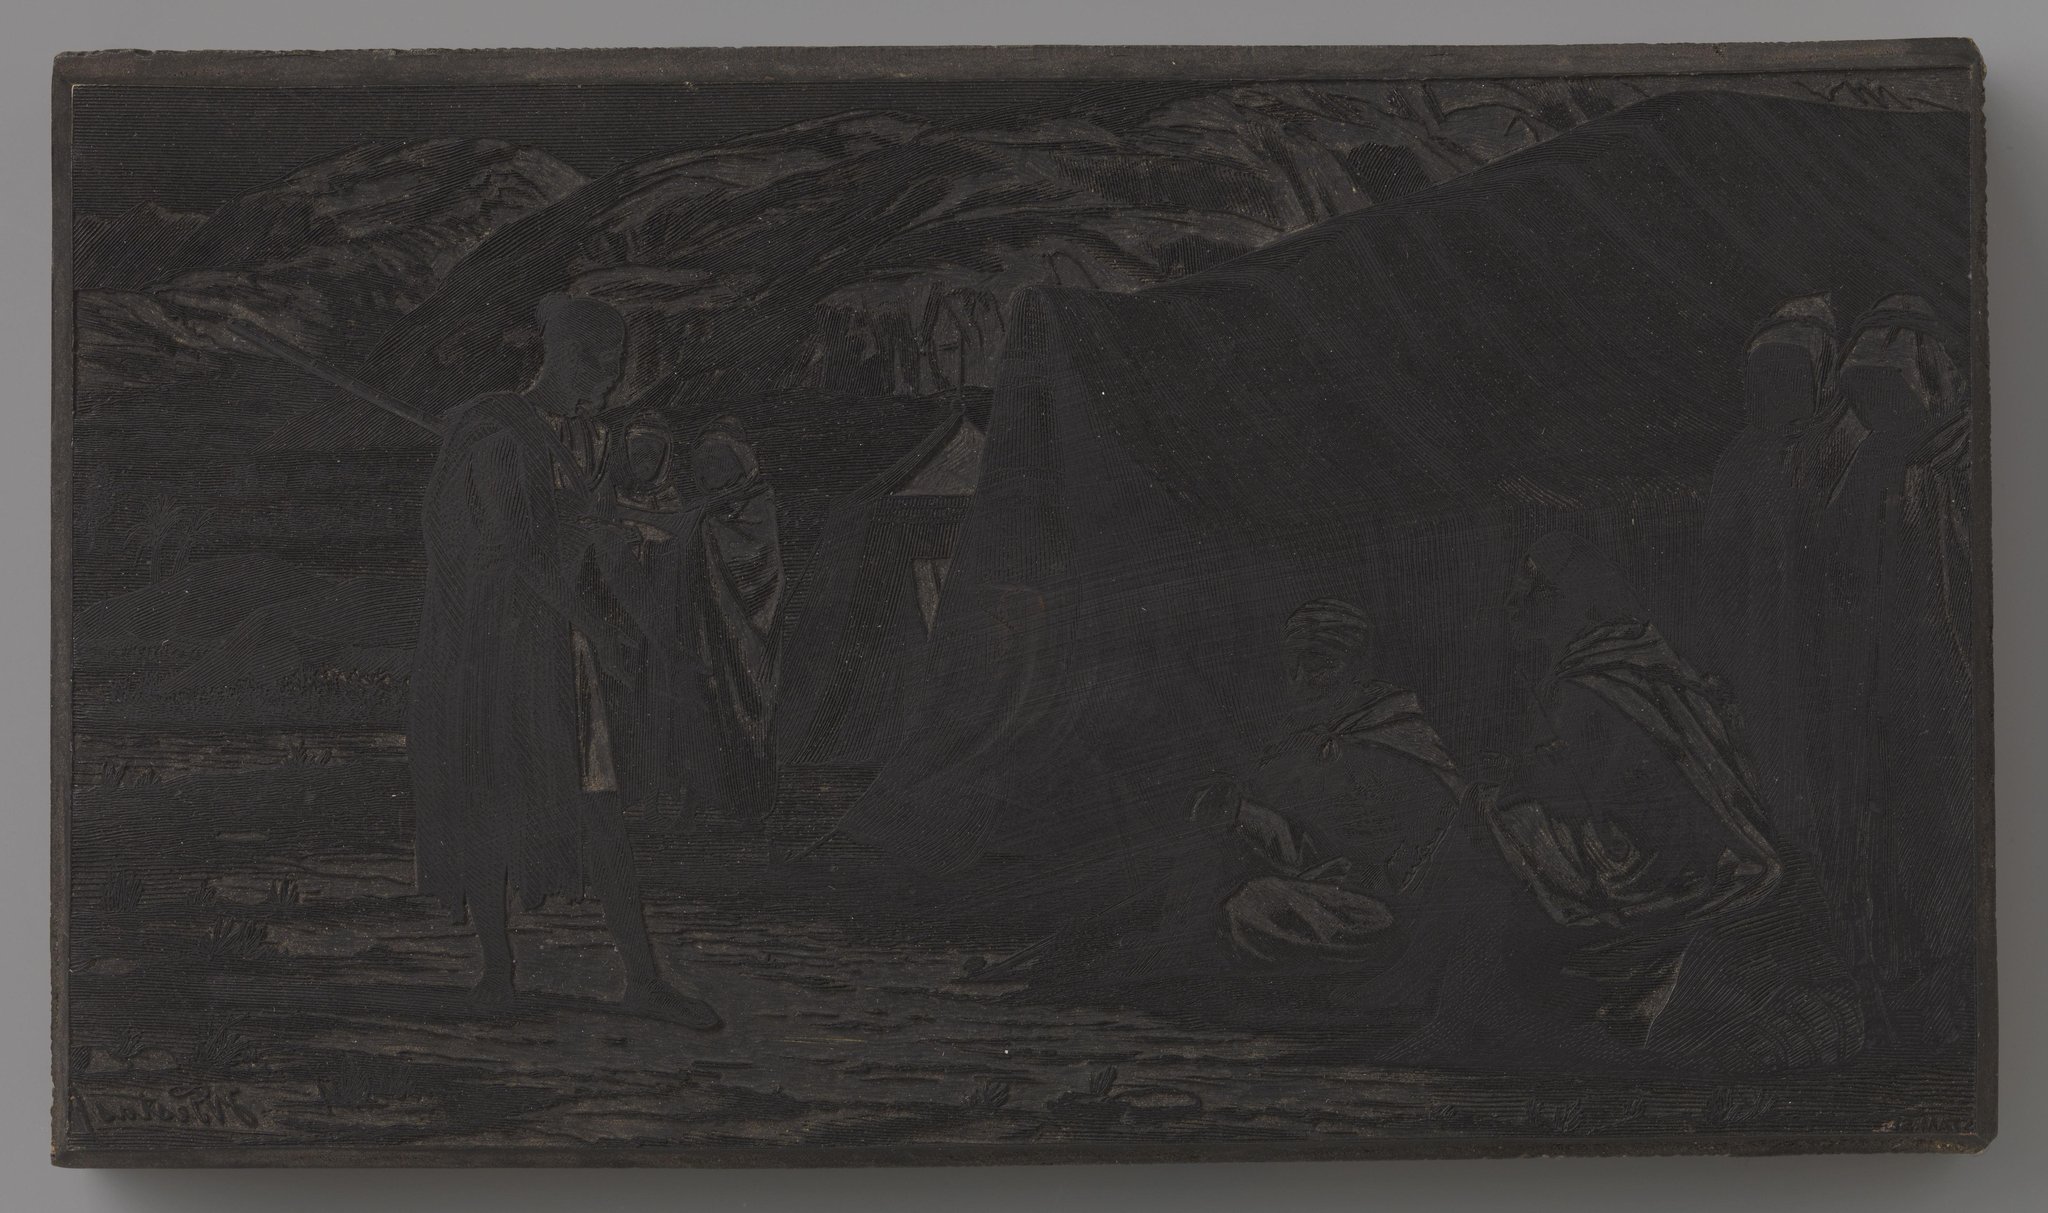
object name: houtblok kopshout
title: Zwarte man en vier witte mannen voor een tent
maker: willem hendrik stam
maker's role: print maker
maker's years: 1831-1874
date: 1844-1874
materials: wood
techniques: engraving